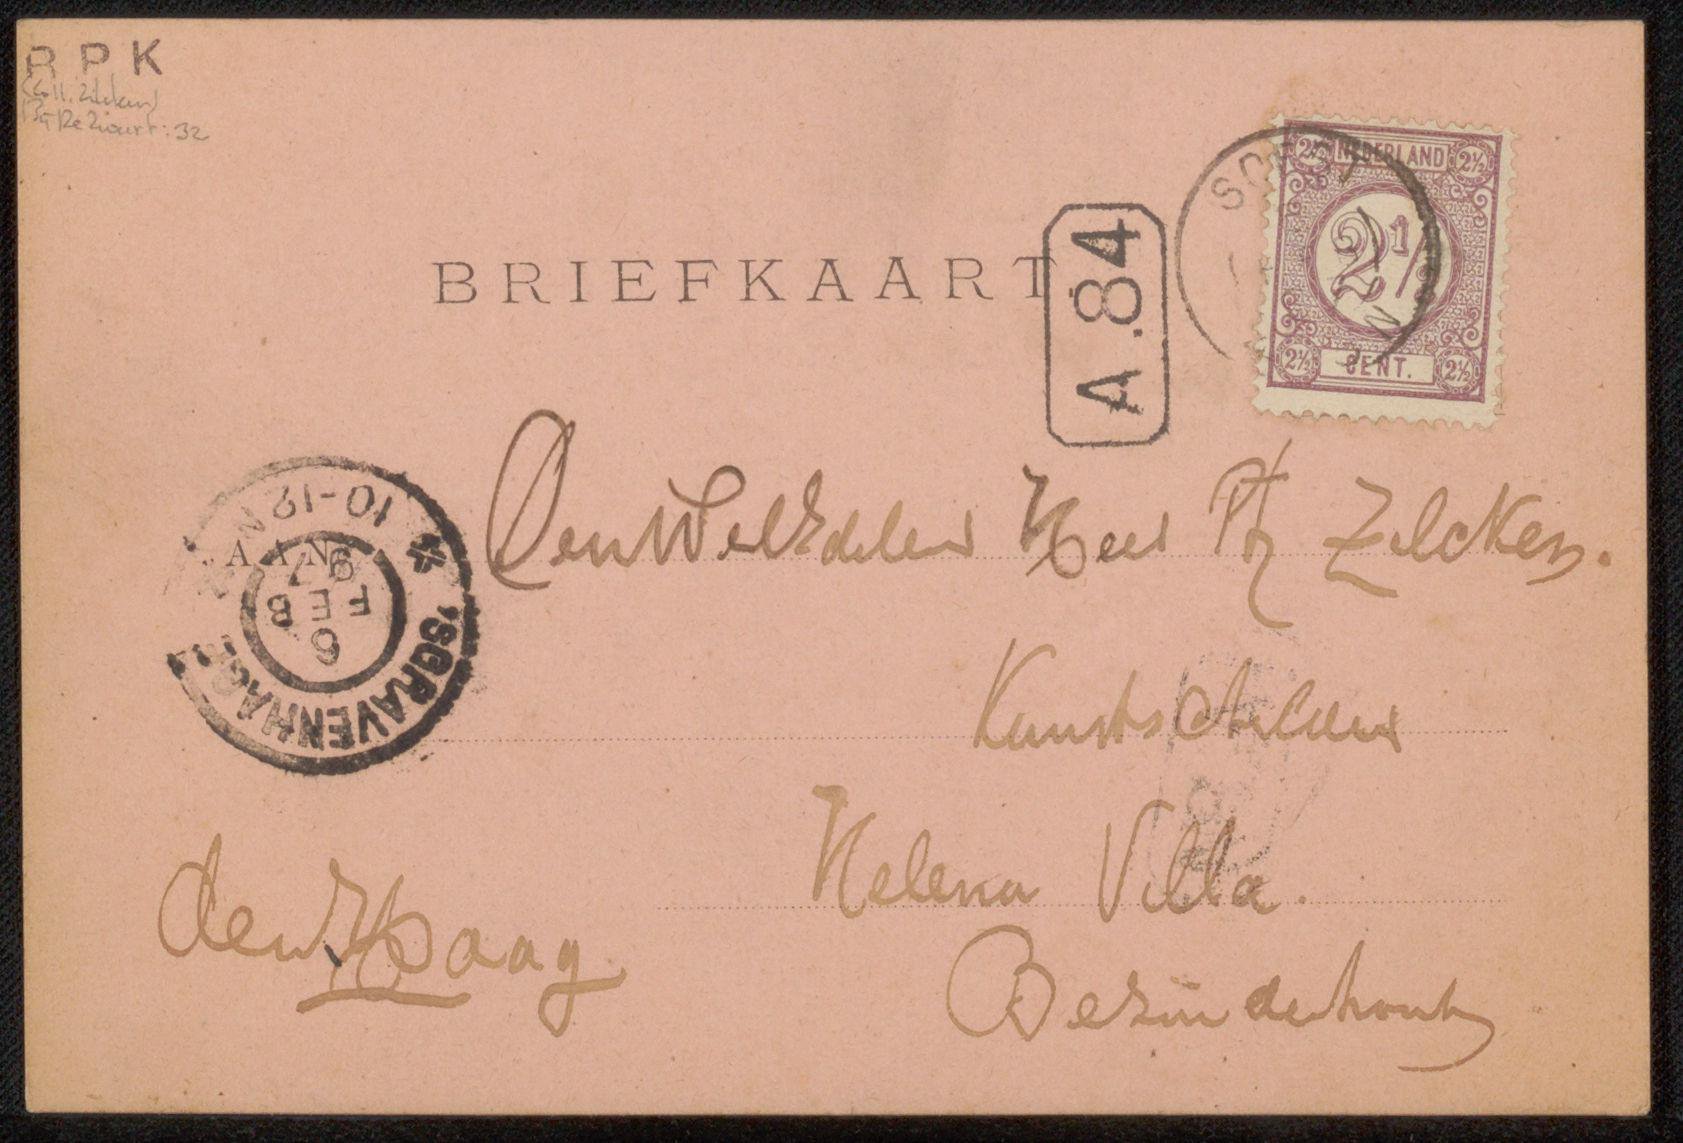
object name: postcard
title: Briefkaart aan Philip Zilcken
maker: willem de zwart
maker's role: draughtsman, painter, print maker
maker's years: 1862-1931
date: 1897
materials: cardboard, ink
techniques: pen, writing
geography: soest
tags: philip zilcken, the hague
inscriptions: collector's mark: ‘RPK’